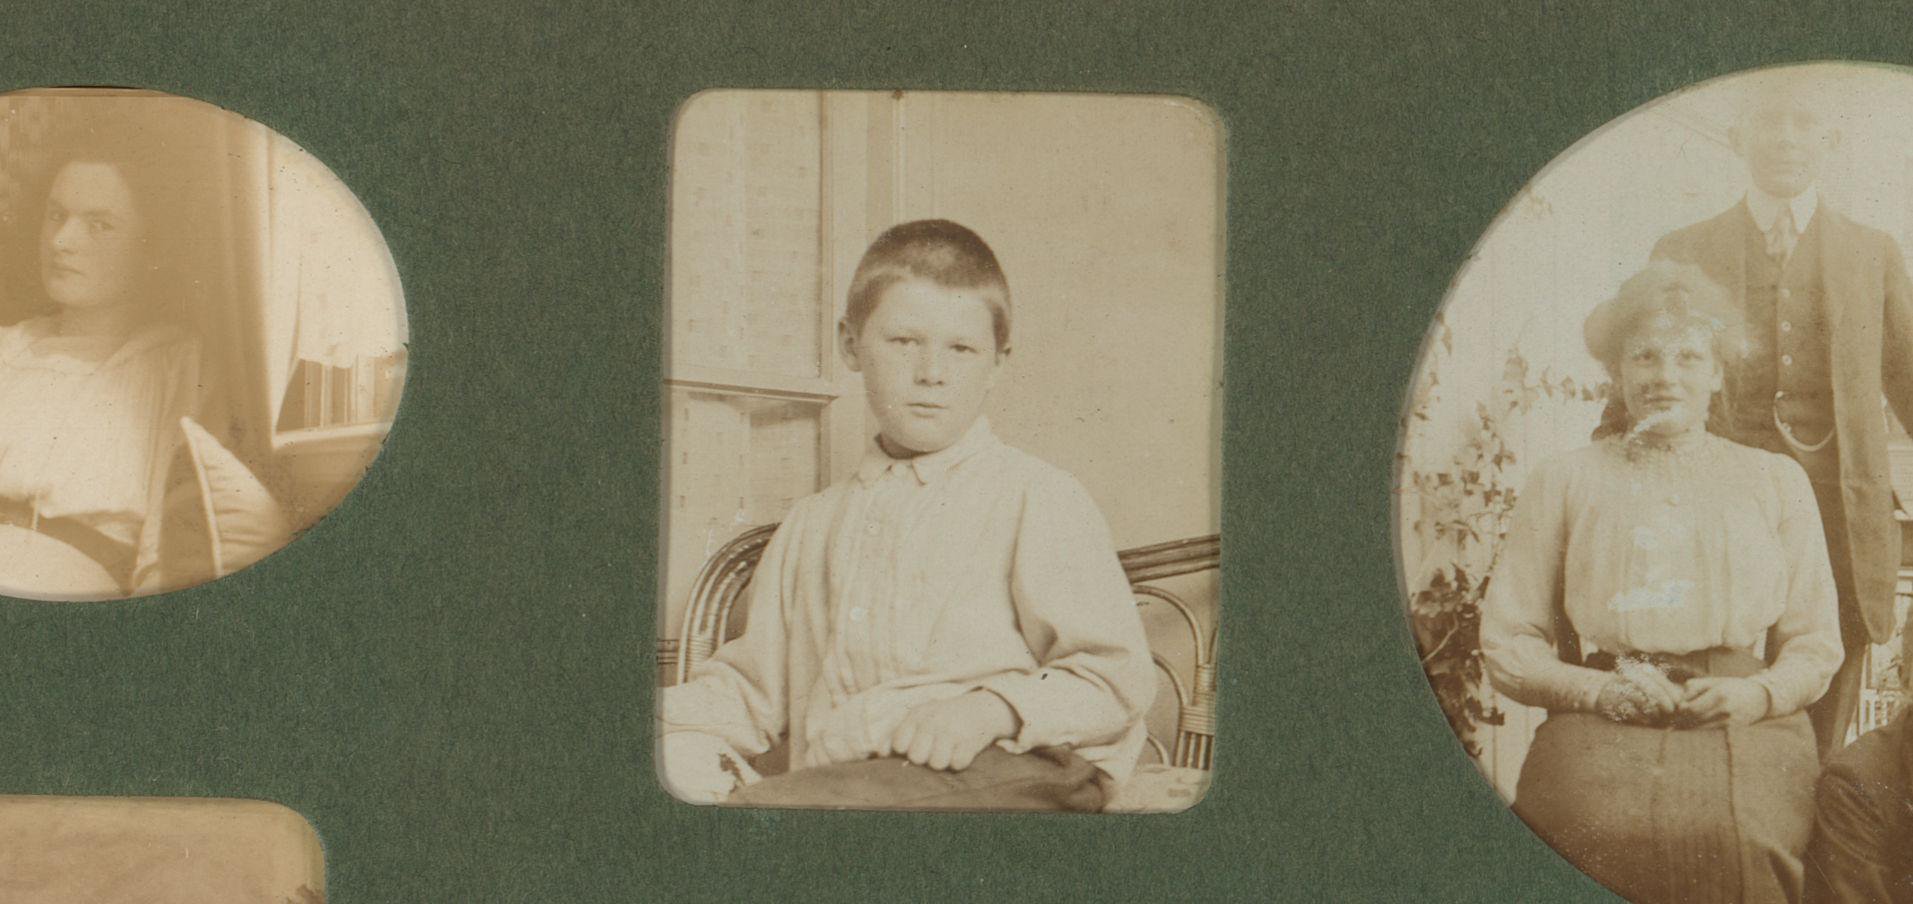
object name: album leaf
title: Portret van een jongen, aangeduid als Hajo Merkus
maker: Anonymous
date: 1910-1912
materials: paper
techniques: gelatin silver print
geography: gelderland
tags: boy (child between toddler and youth), historical persons, gelderland